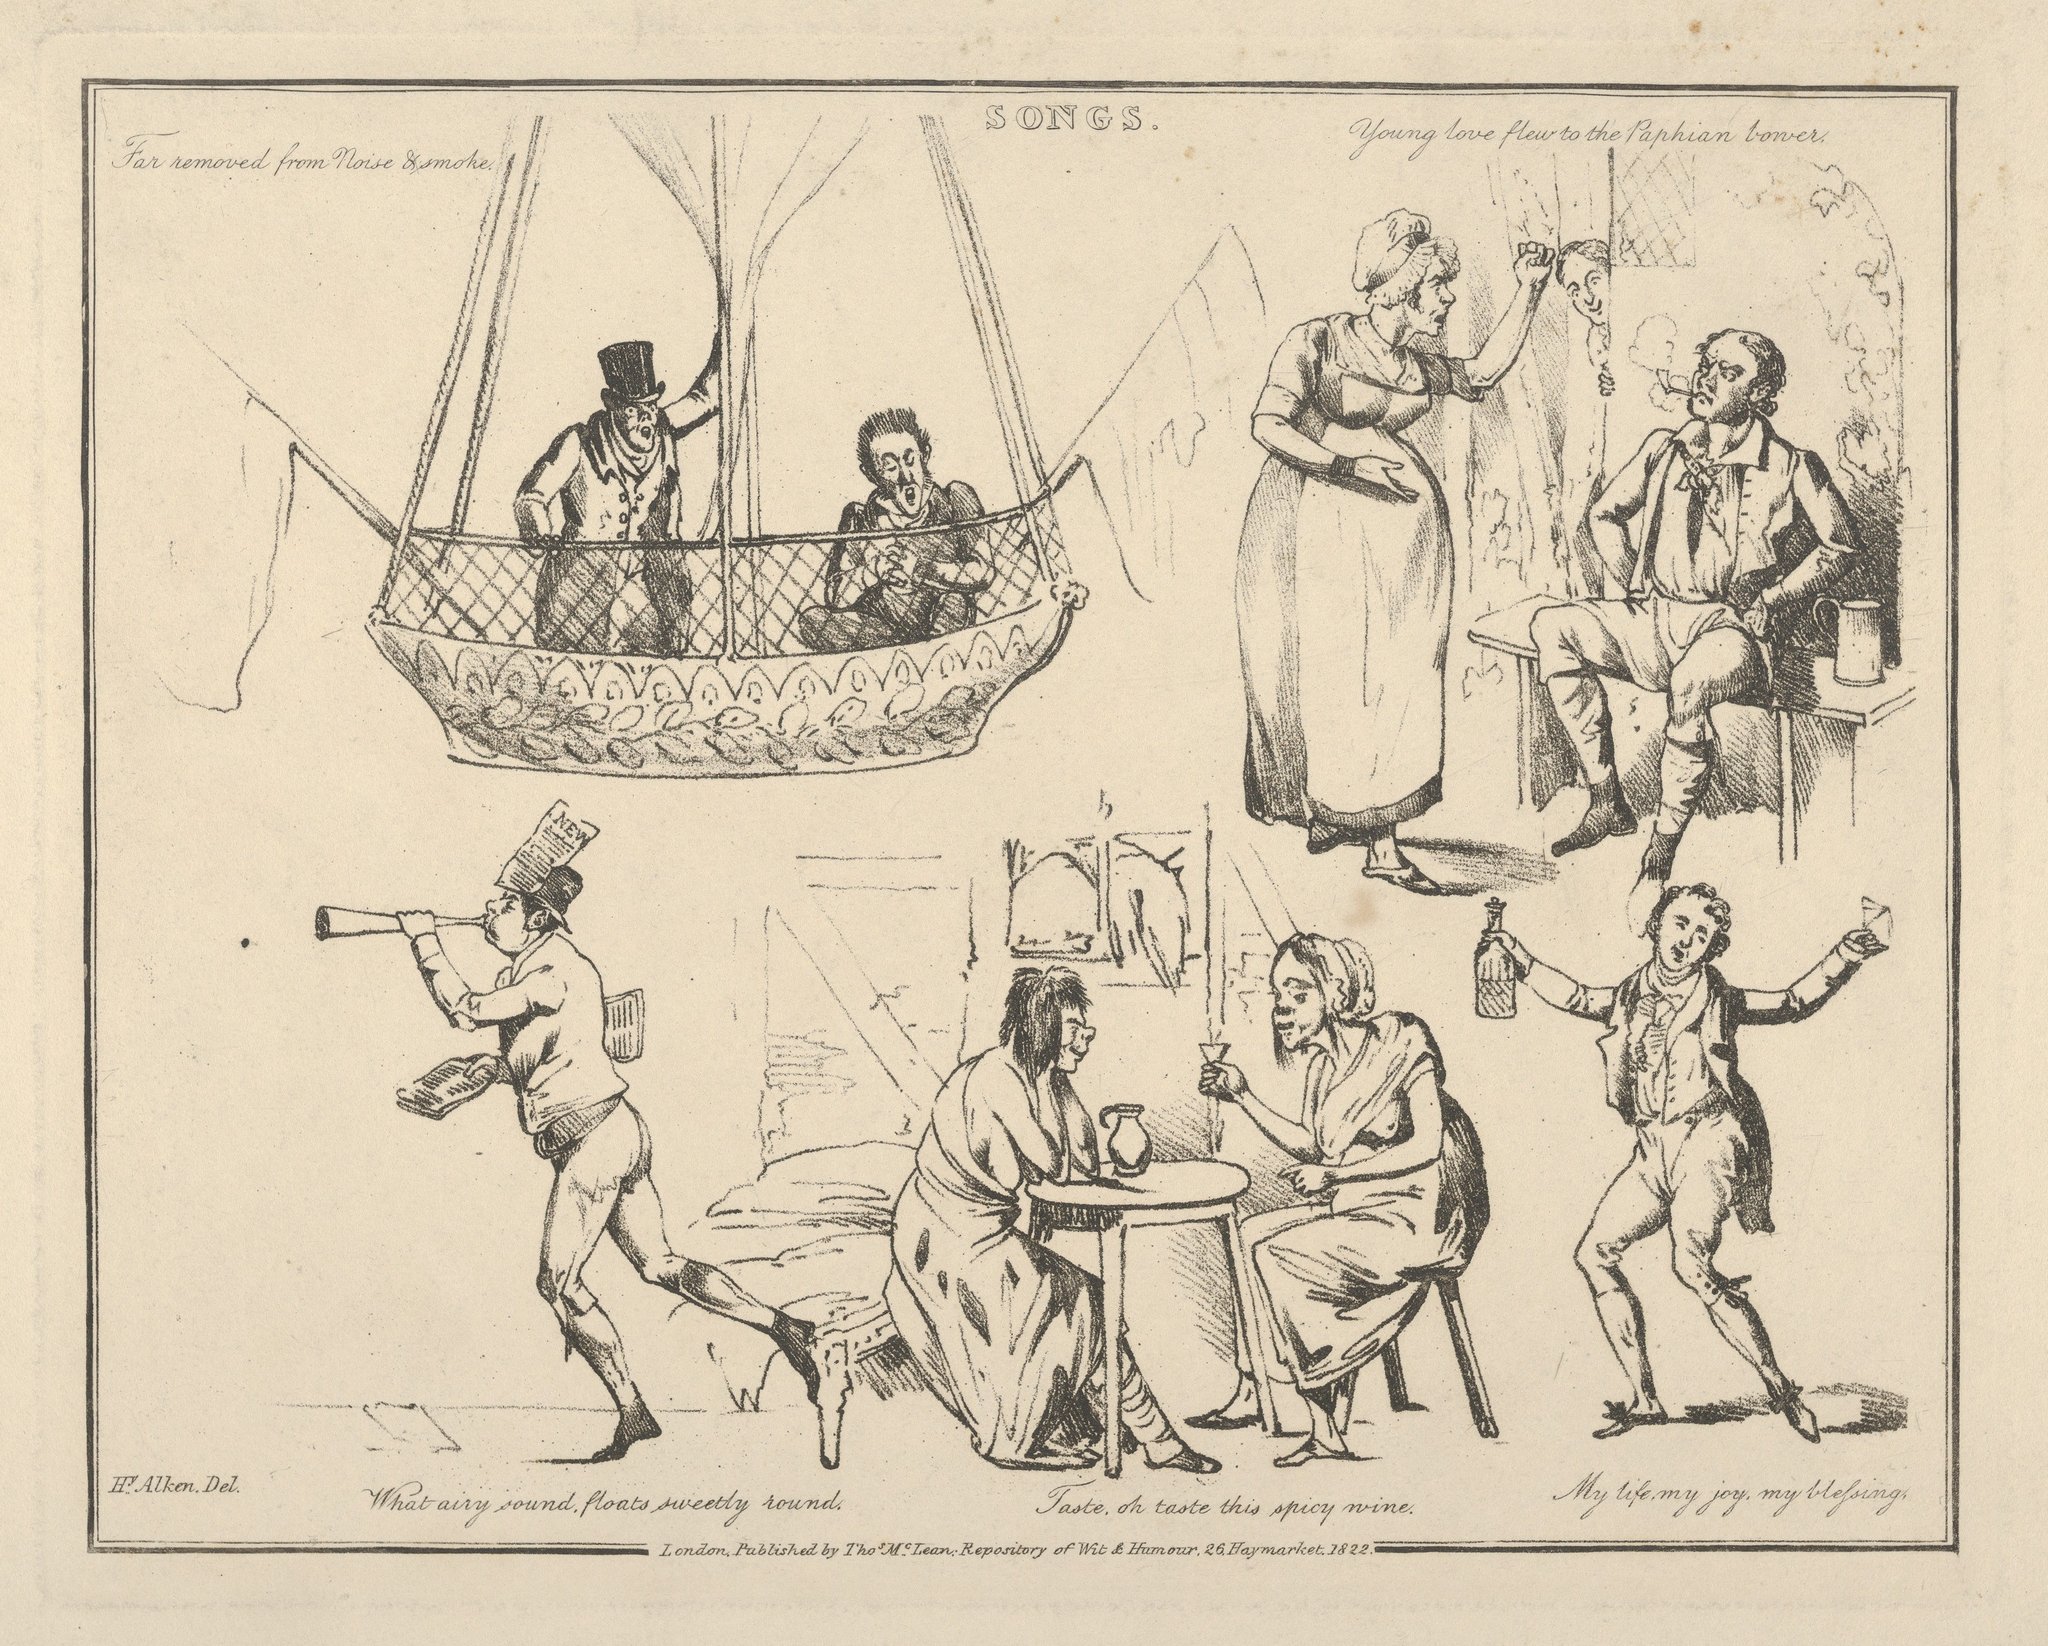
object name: print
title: Songs: "Far removed from Noise & Smoke..."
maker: henry alken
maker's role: artist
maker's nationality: british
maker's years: 1785-1851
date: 1822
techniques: etching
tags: dance,satire,men,women